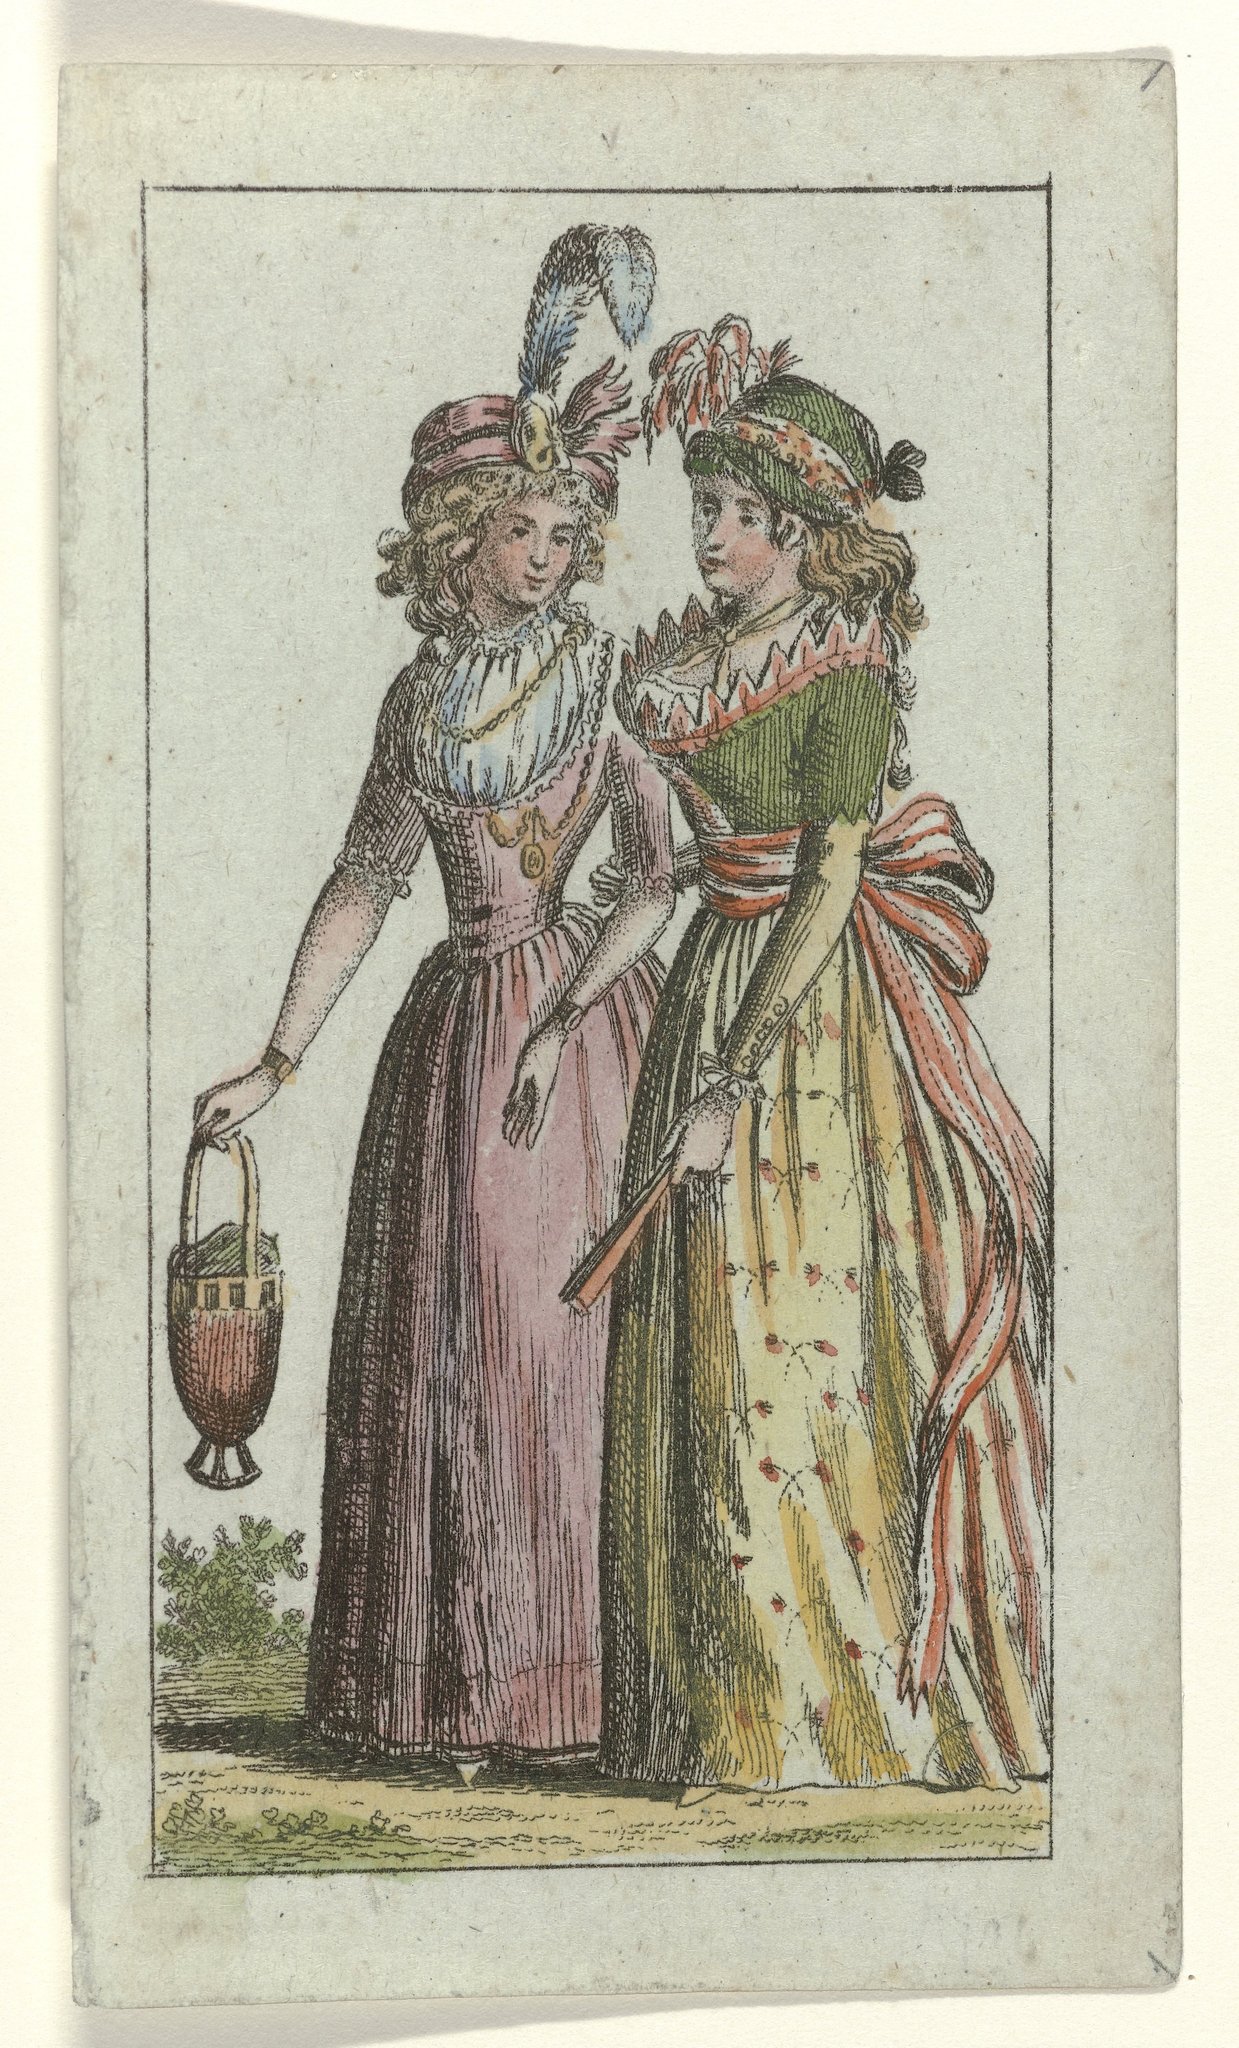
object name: almanac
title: Modes Révolutionaires, 1796: Twee vrouwen met op het hoofd een tulband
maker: Anonymous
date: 1796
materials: paper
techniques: etching, hand coloring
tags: head-gear: turban (+ women's clothes), calendar, almanac, fashion plates, dress, gown (+ women's clothes), fan (+ women's clothes), piece of clothing covering the breast or décolleté (fichu) (+ women's clothes), bracelet, wristlet (+ women's clothes)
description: Twee vrouwen, naar links lopend, gearmd. Links: japon met driekwart mouwen. Rechts: japon met lange mouwen, gekartelde kraag en om het middel een gestreepte sjerp. Beiden dragen op het hoofd een tulband met veren. Verdere accessoires: kettingen, gestrikte halsdoek, armbanden, tas of mand, waaier.